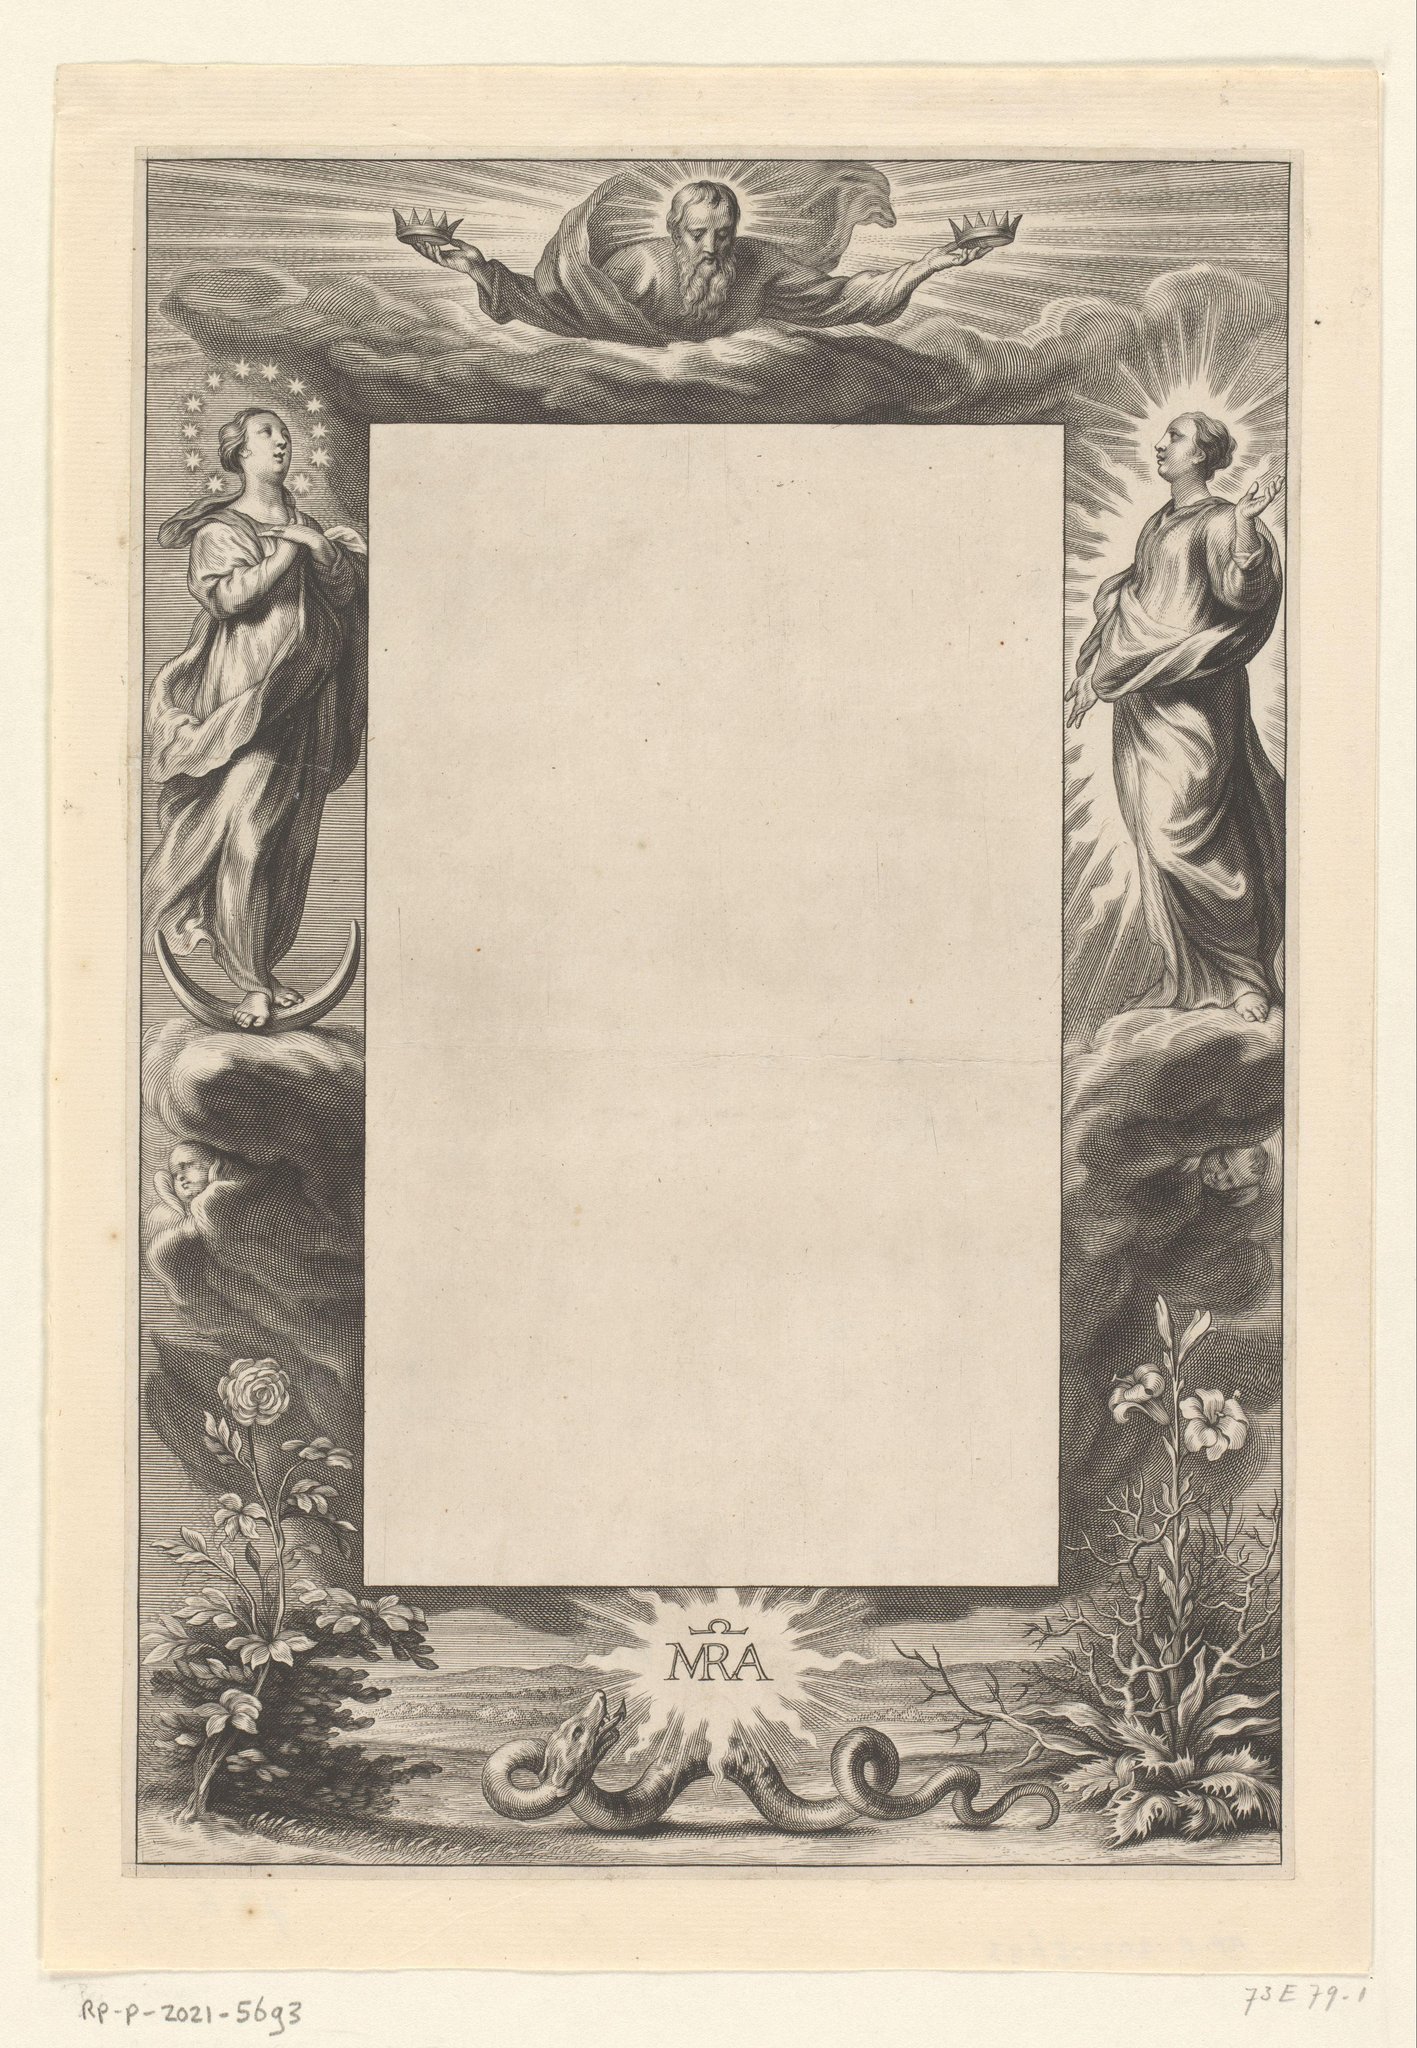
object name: print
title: Omlijsting ter ere van Maria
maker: Anonymous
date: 1650-1730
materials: paper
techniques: engraving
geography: southern netherlands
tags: madonna on the crescent of the moon (sometimes called queen of heaven) (in mandorla), coronation of mary by god the father, god the father, monograms of mary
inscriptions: collector's mark: Lugt 2228, number: ‘no. 354-2’, stamp: ‘ICON’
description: Een omlijsting met midden onder het Mariamonogram. Onder het monogram de overwonnen slang van het kwaad. In de onderste hoeken een bloeiende roos en een bloeiende lelie, symbolen voor de Maagd Maria. Links Maria op de maansikkel, rechts een andere beeltenis van Maria of een andere heilige. Midden boven God de Vader met twee kronen.